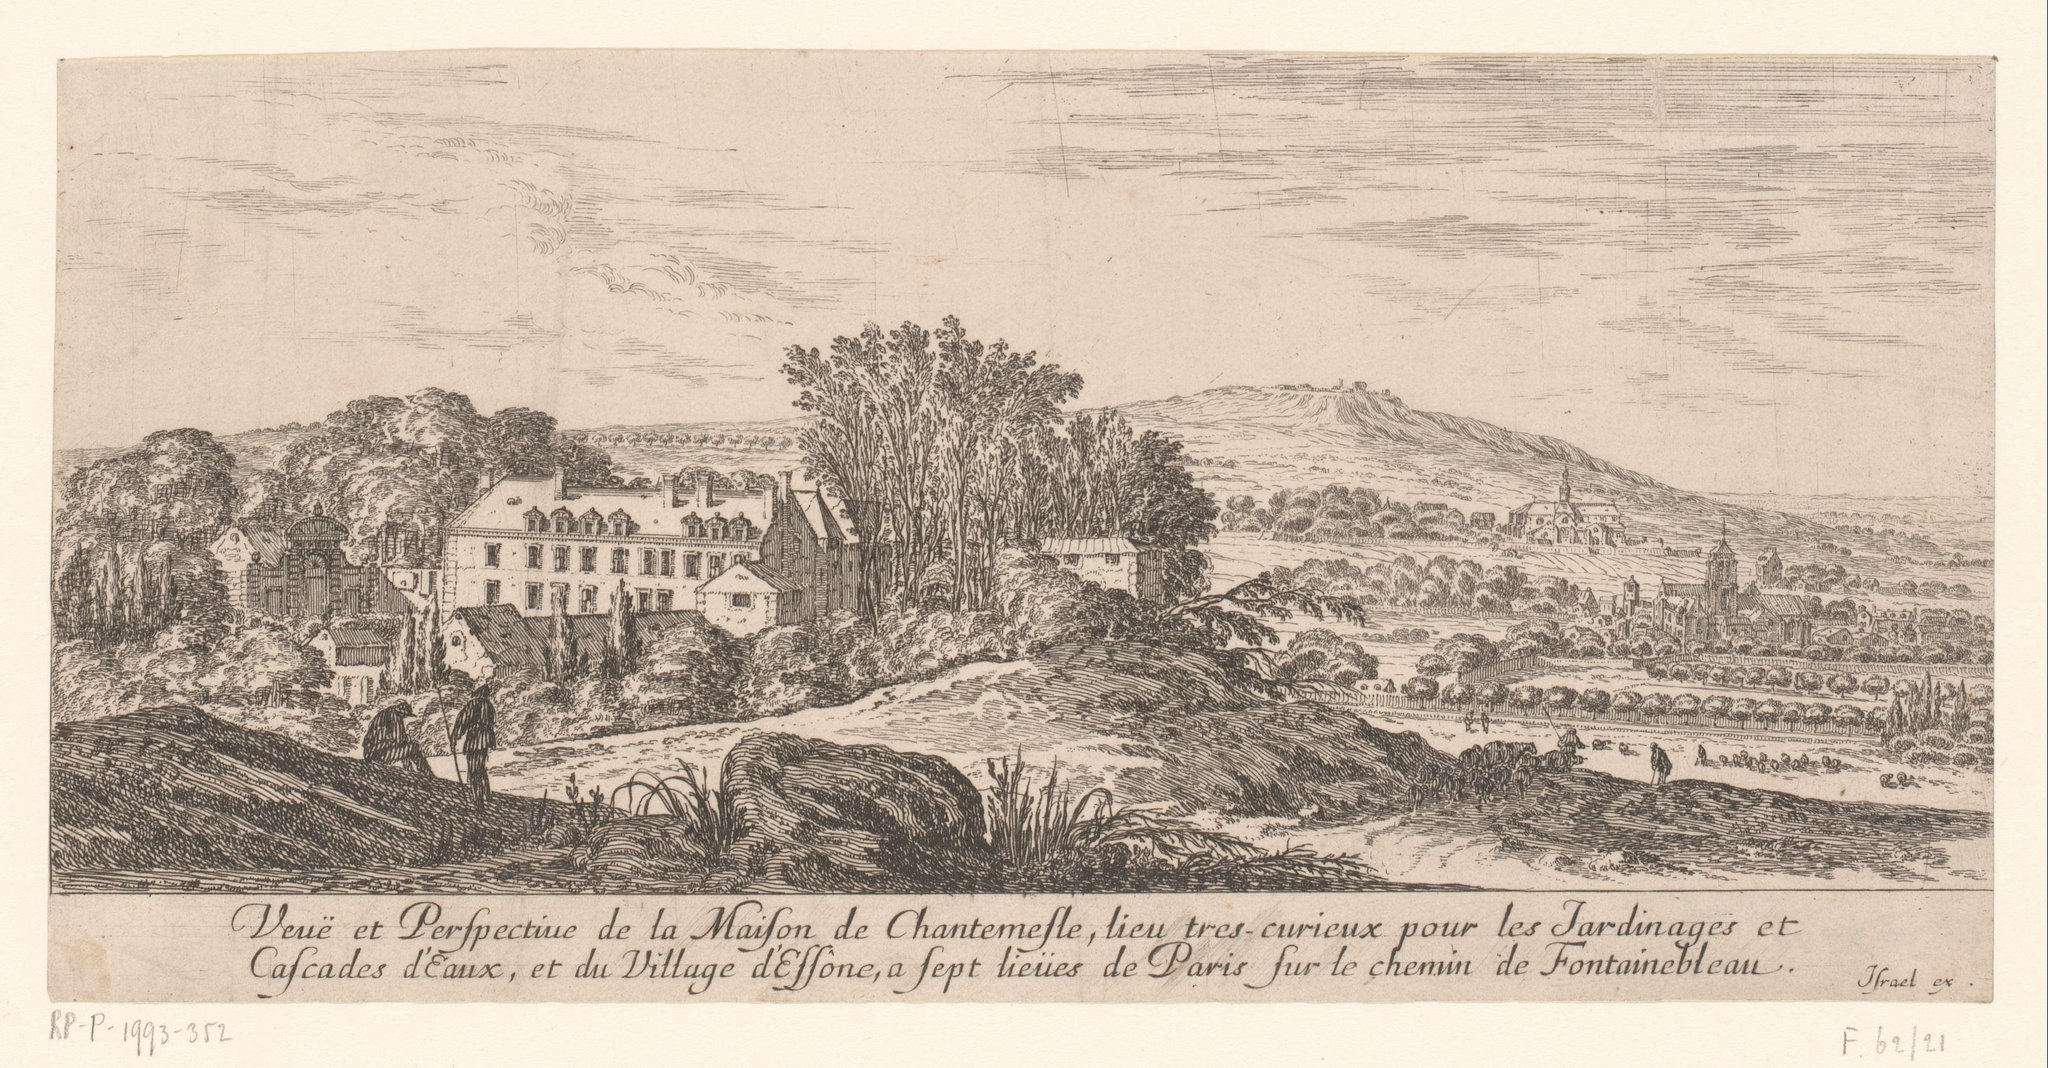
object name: print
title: Gezicht op het kasteel van Chantemesle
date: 1651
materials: paper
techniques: engraving, etching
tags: landscape with tower or castle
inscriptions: collector's mark: Lugt 2228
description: Prent maakt deel uit van een ongenummerde serie van 22 prenten.